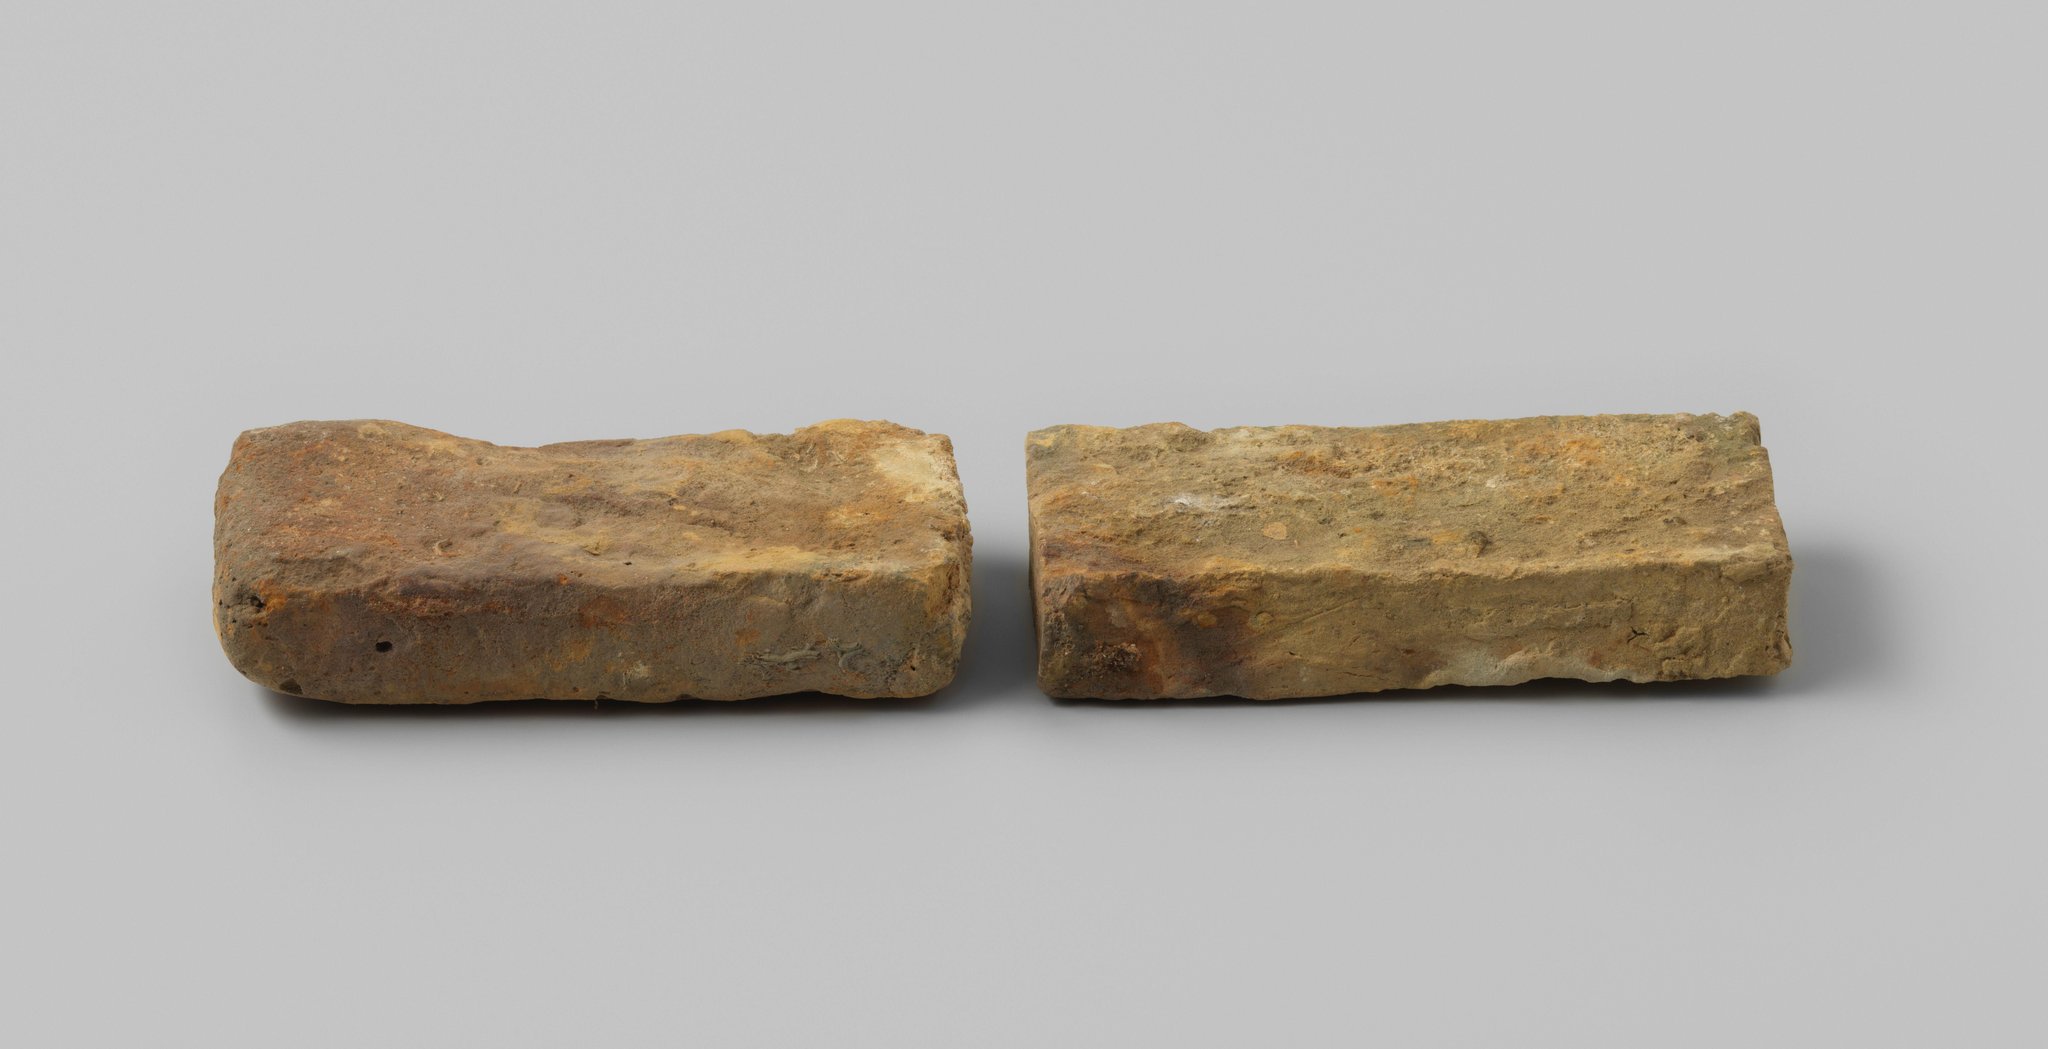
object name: brick clay product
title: Bakstenen uit het wrak van de Oostindiëvaarder Hollandia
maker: Anonymous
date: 1700-1743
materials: brick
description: Zesendertig bakstenen uit het wrak van de Oostindiëvaarder Hollandia. Constructional elements, brick. Allemaal ongeveer dezelfde afmetingen.